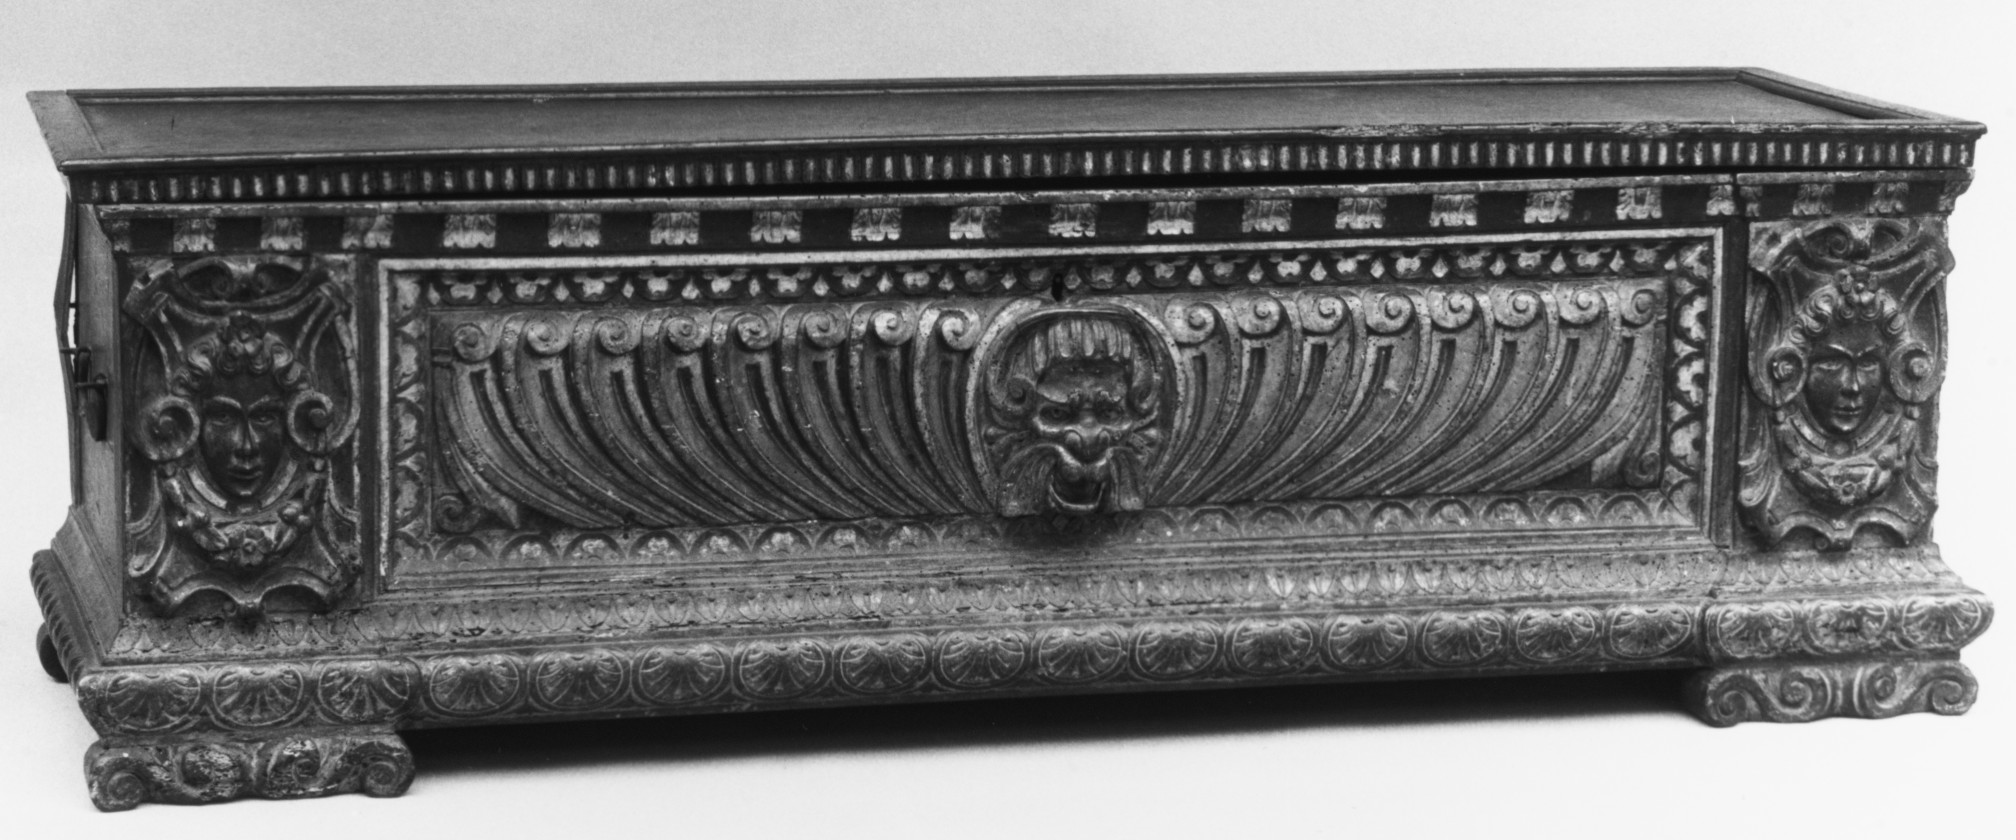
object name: cassone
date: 1551-1600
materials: wood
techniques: gilding